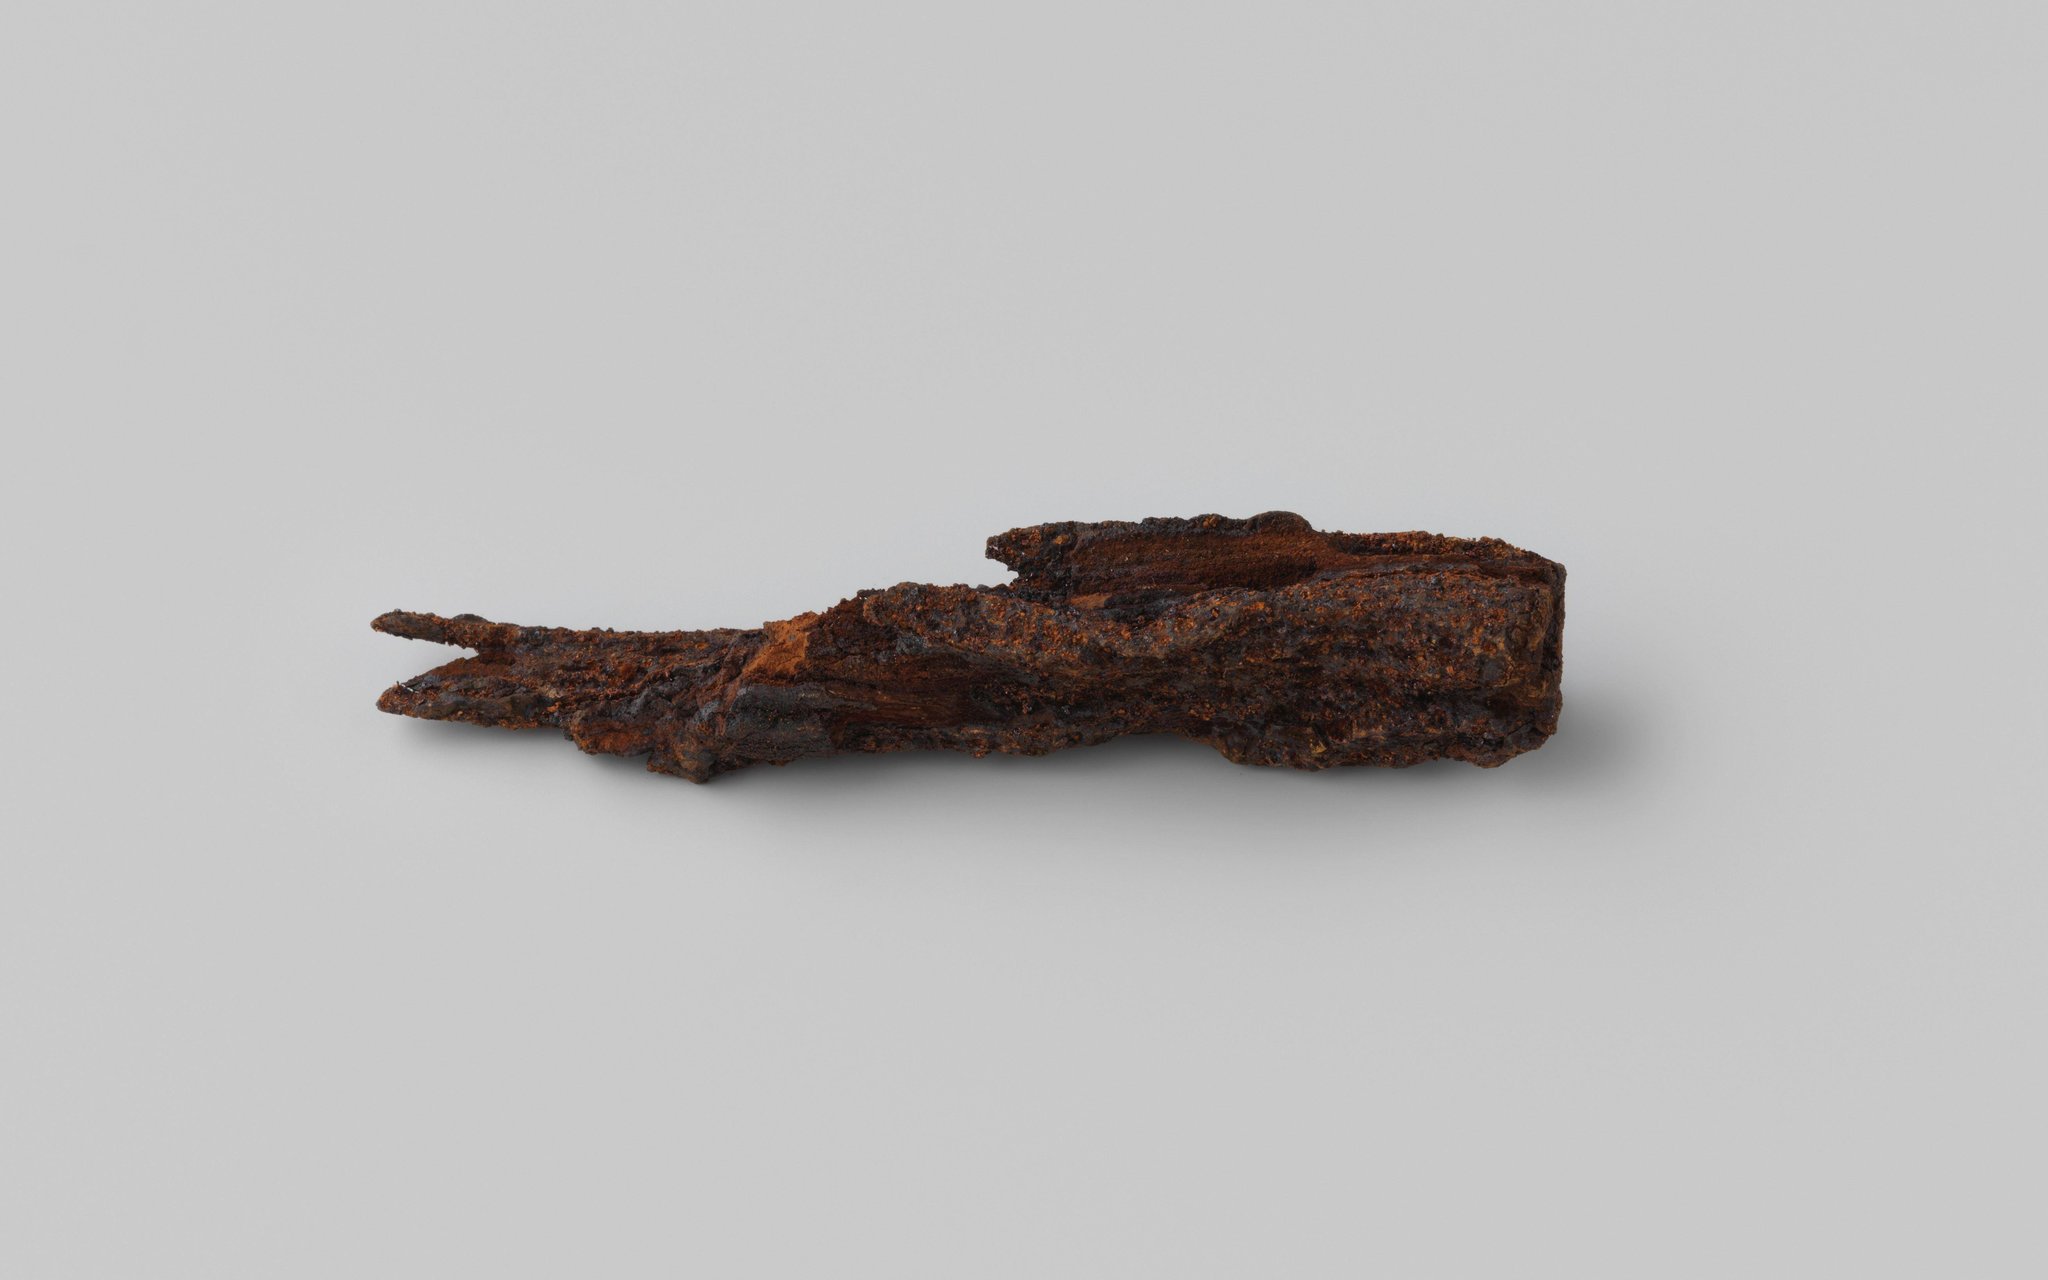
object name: fragment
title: Fragment of onderdeel uit het wrak van de Oost-Indiëvaarder Hollandia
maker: Anonymous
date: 1743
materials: iron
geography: netherlands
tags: verenigde oostindische compagnie, hollandia (schip), annet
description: Varied parts or fragments, bar(-shaped) fragments; fragm, heavily eroded, broken, sim. 80H1763.